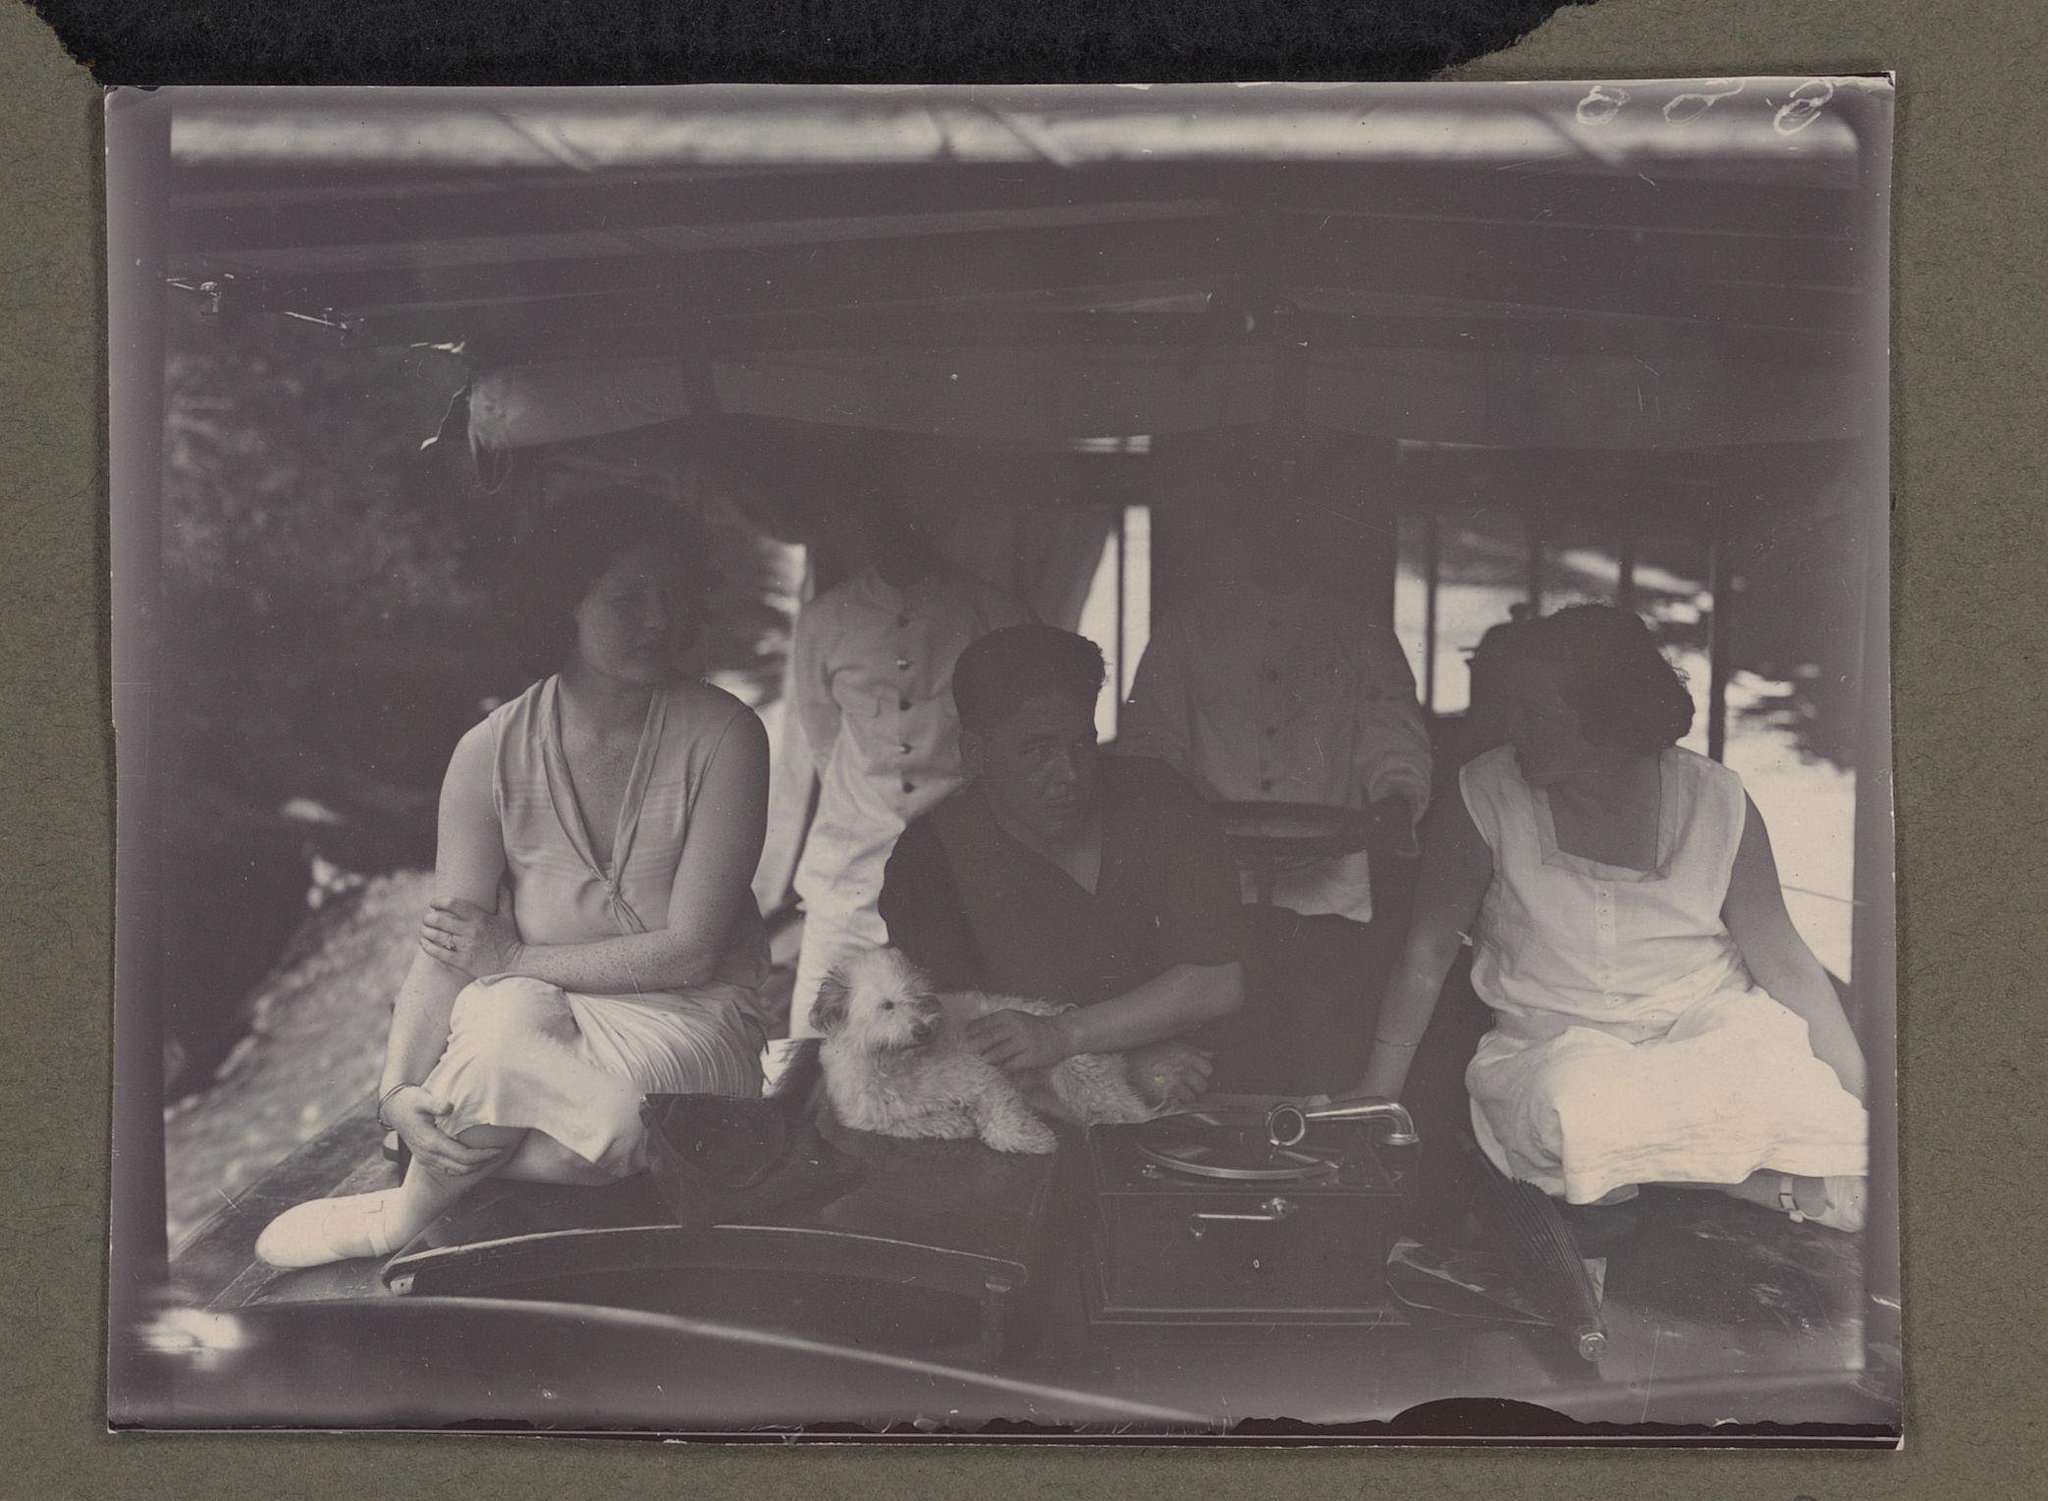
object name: photograph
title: Bezoek aan een dorp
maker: Anonymous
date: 1925-1927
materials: photographic support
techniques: photography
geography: suriname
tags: jetten, familie, moengo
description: Bezoek aan een inlands dorp door een groep Nederlanders waaronder het echtpaar Jetten. Foto op een bladzijde van een los albumblad waarvan een hoek met twee foto's is uitgescheurd. Onderdeel van het ensemble met foto's van de familie van ingenieur Jetten in de mijnbouwstad Moengo in Suriname.